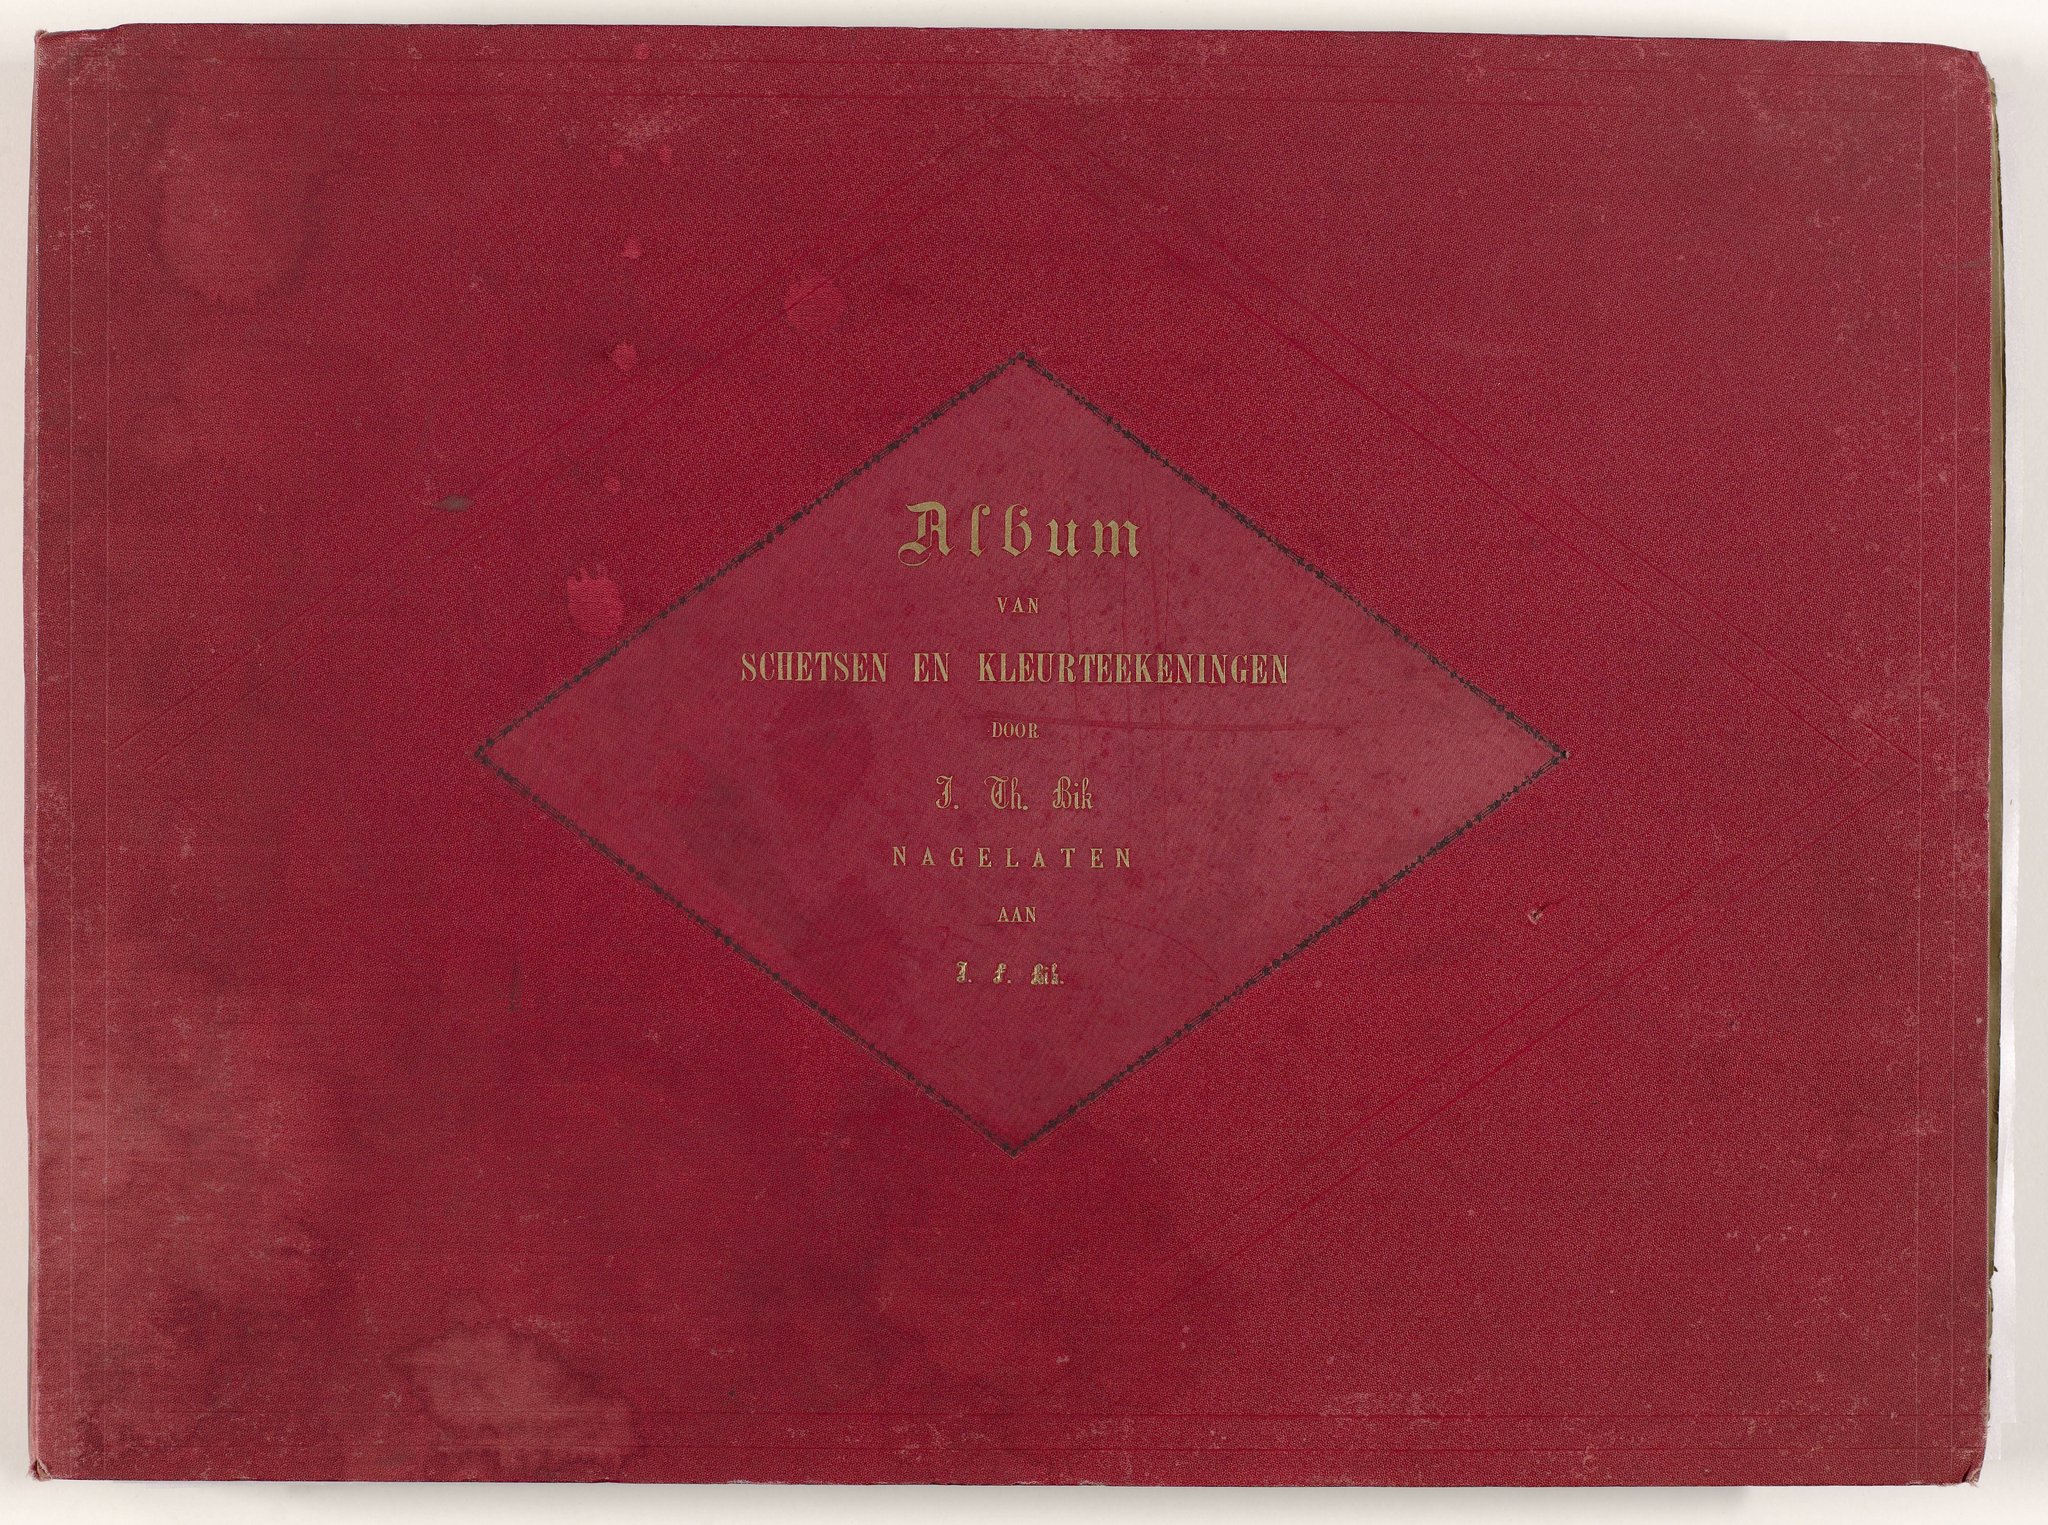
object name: tekeningenalbum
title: Album van Schetsen en Kleurtekeningen door J. Th. Bik nagelaten aan J.F. Bik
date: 1815-1847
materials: chalk, ink, linen, paper, pencil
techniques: bookbinding, brush, lithograph, pen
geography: batavia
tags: caspar georg carl reinwardt, diponegoro, city-view, and landscape with man-made constructions, animals, landscapes in the temperate zone, volcano, java, indonesia, cape of good hope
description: Album met een titelpagina, 70 tekeningen, acht prenten en één document. Het album opent met gezichten rond Kaap de Goede Hoop, het merendeel van de tekeningen geven West-Java en de Molukken weer. Het hele album telt 98 bladen, deels blanco. Met voorin een paar bladen documentatie, een handgeschreven indexblad en een handgeschreven notitie van Jannes Theodorus Bik, gedateerd 3 juni 1871 te Batavia. Adrianus Theodorus en Jannes Theodorus Bik vergezelden Caspar Georg Carl Reinwardt tijdens diens reis naar Indonesië.